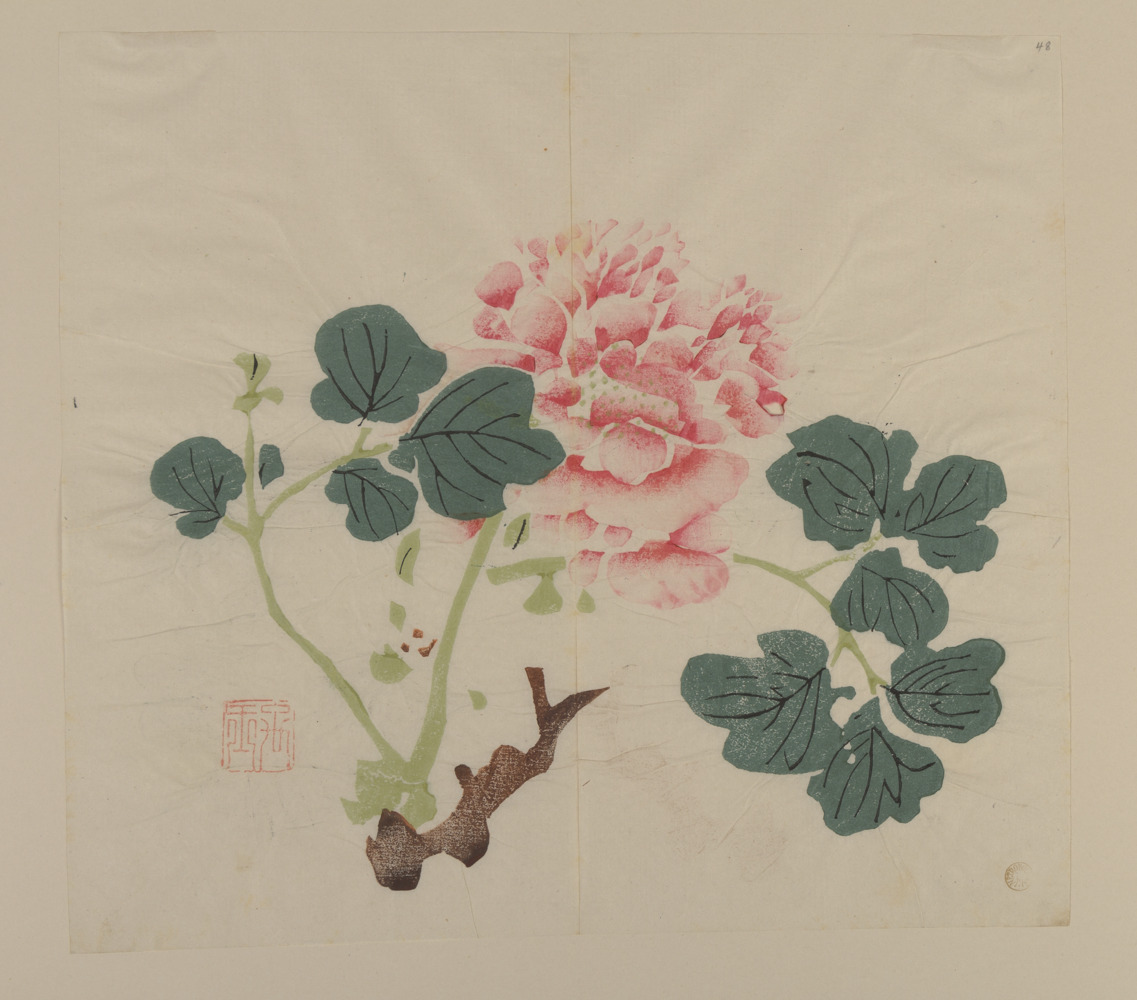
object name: print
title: Page from Shi Zhu Zhai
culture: chinese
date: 1736-1795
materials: ink, paper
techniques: polychrome, woodblock print